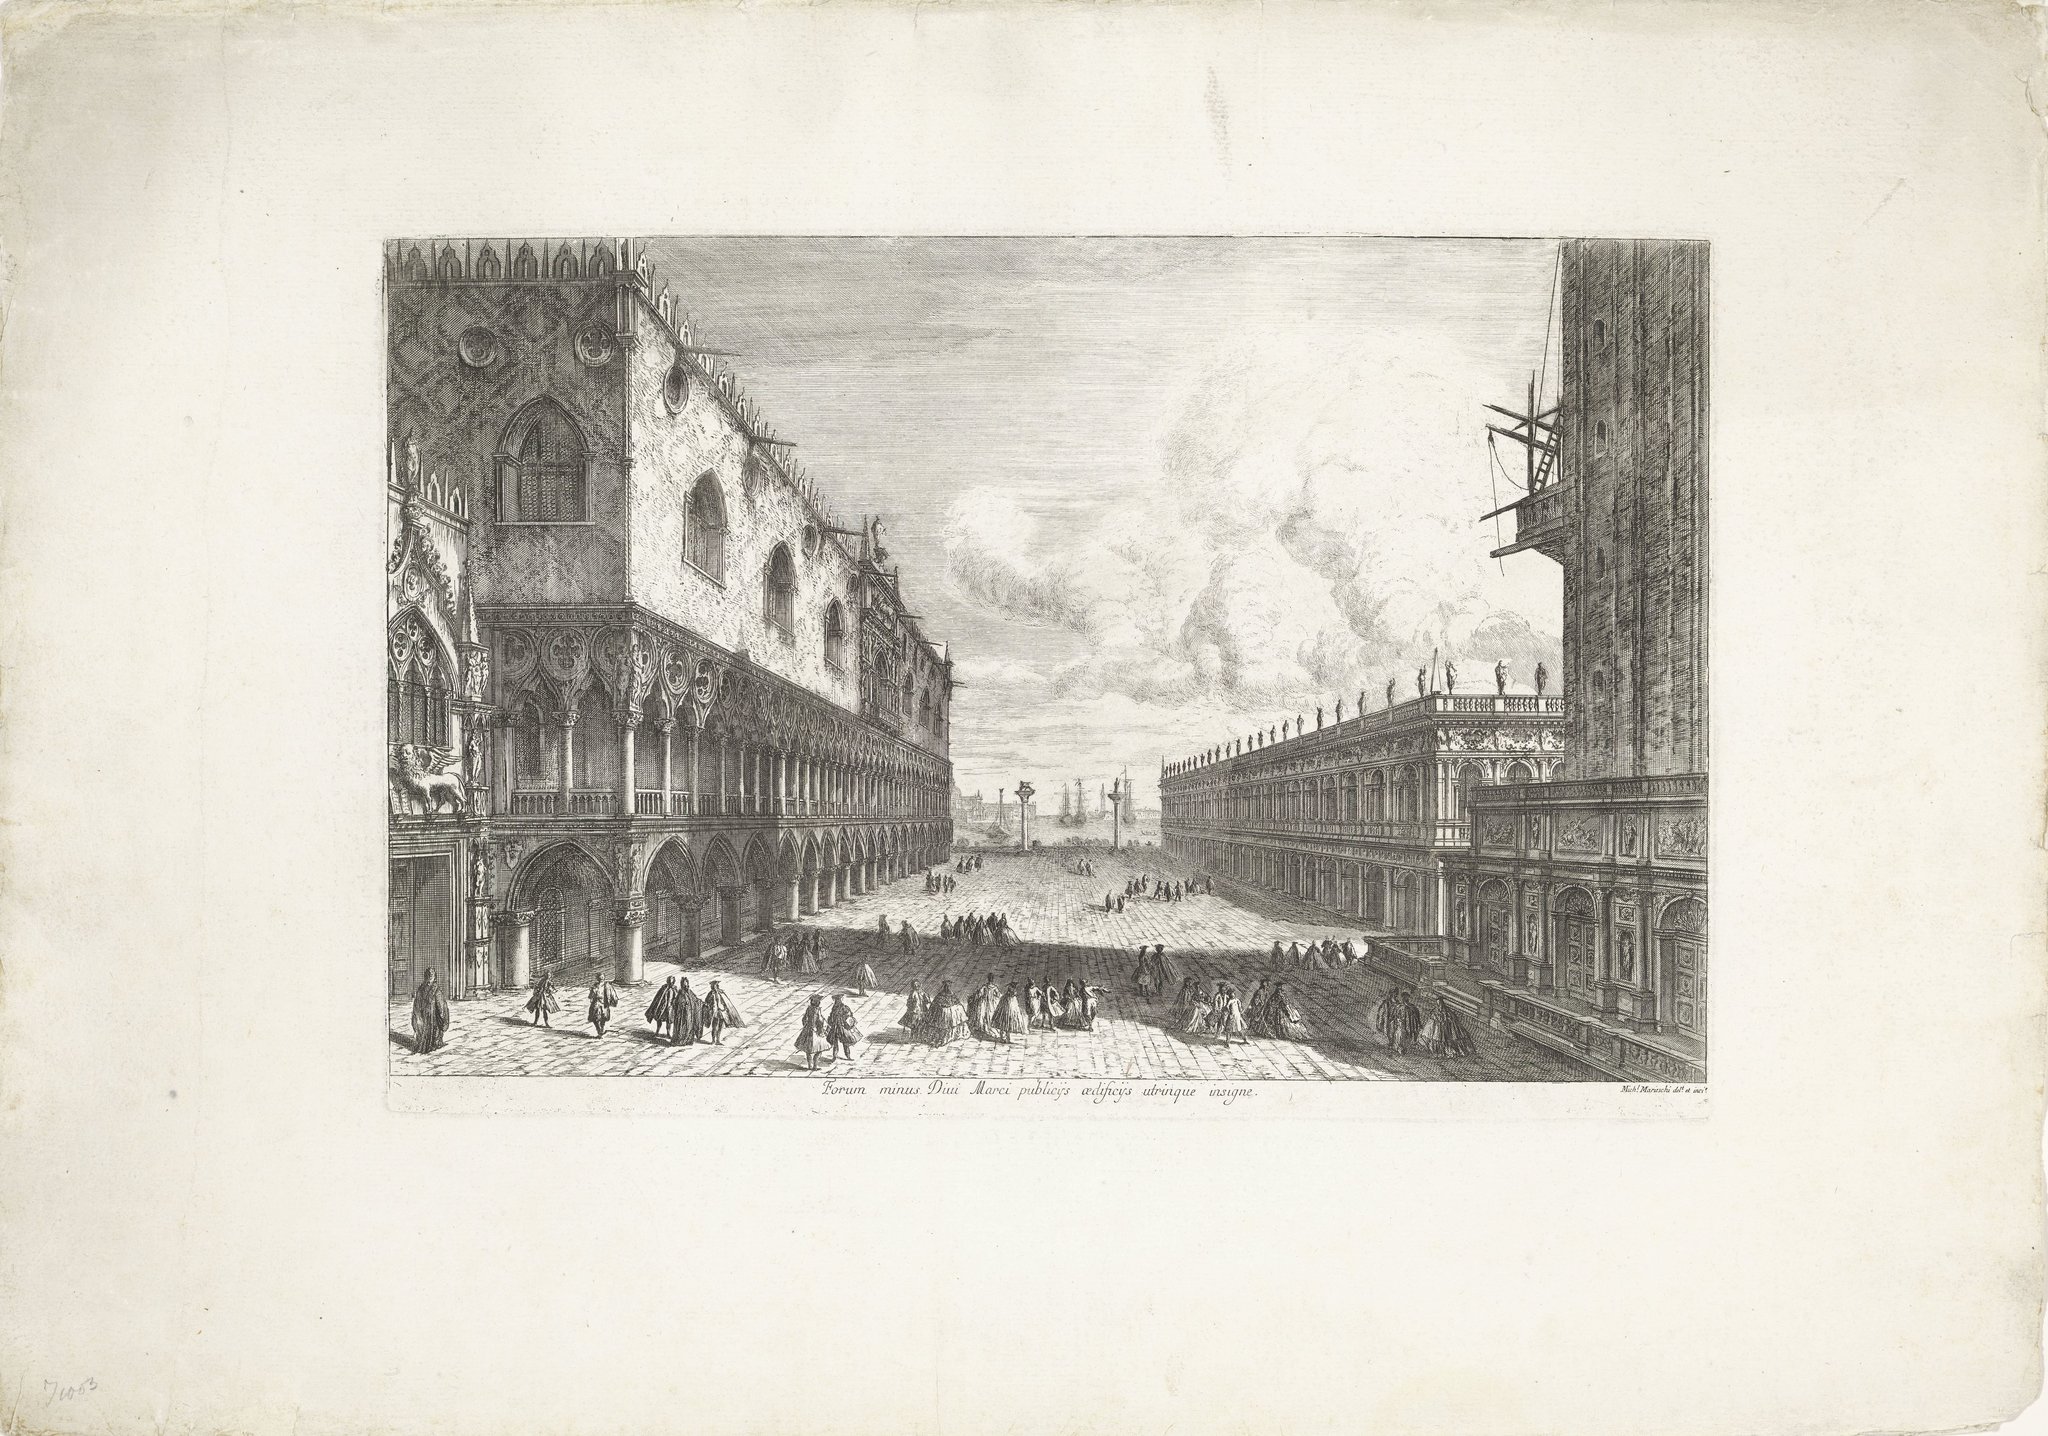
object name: print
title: Gezichten op Venetië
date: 1741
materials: paper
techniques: engraving, etching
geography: venice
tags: square, place, circus, etc., city-view, and landscape with man-made constructions, palace, public library, venice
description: Gezicht op het San Marco Plein in Venetië met links het Palazzo Ducale en rechts de Biblioteca Nazionale Marciana.